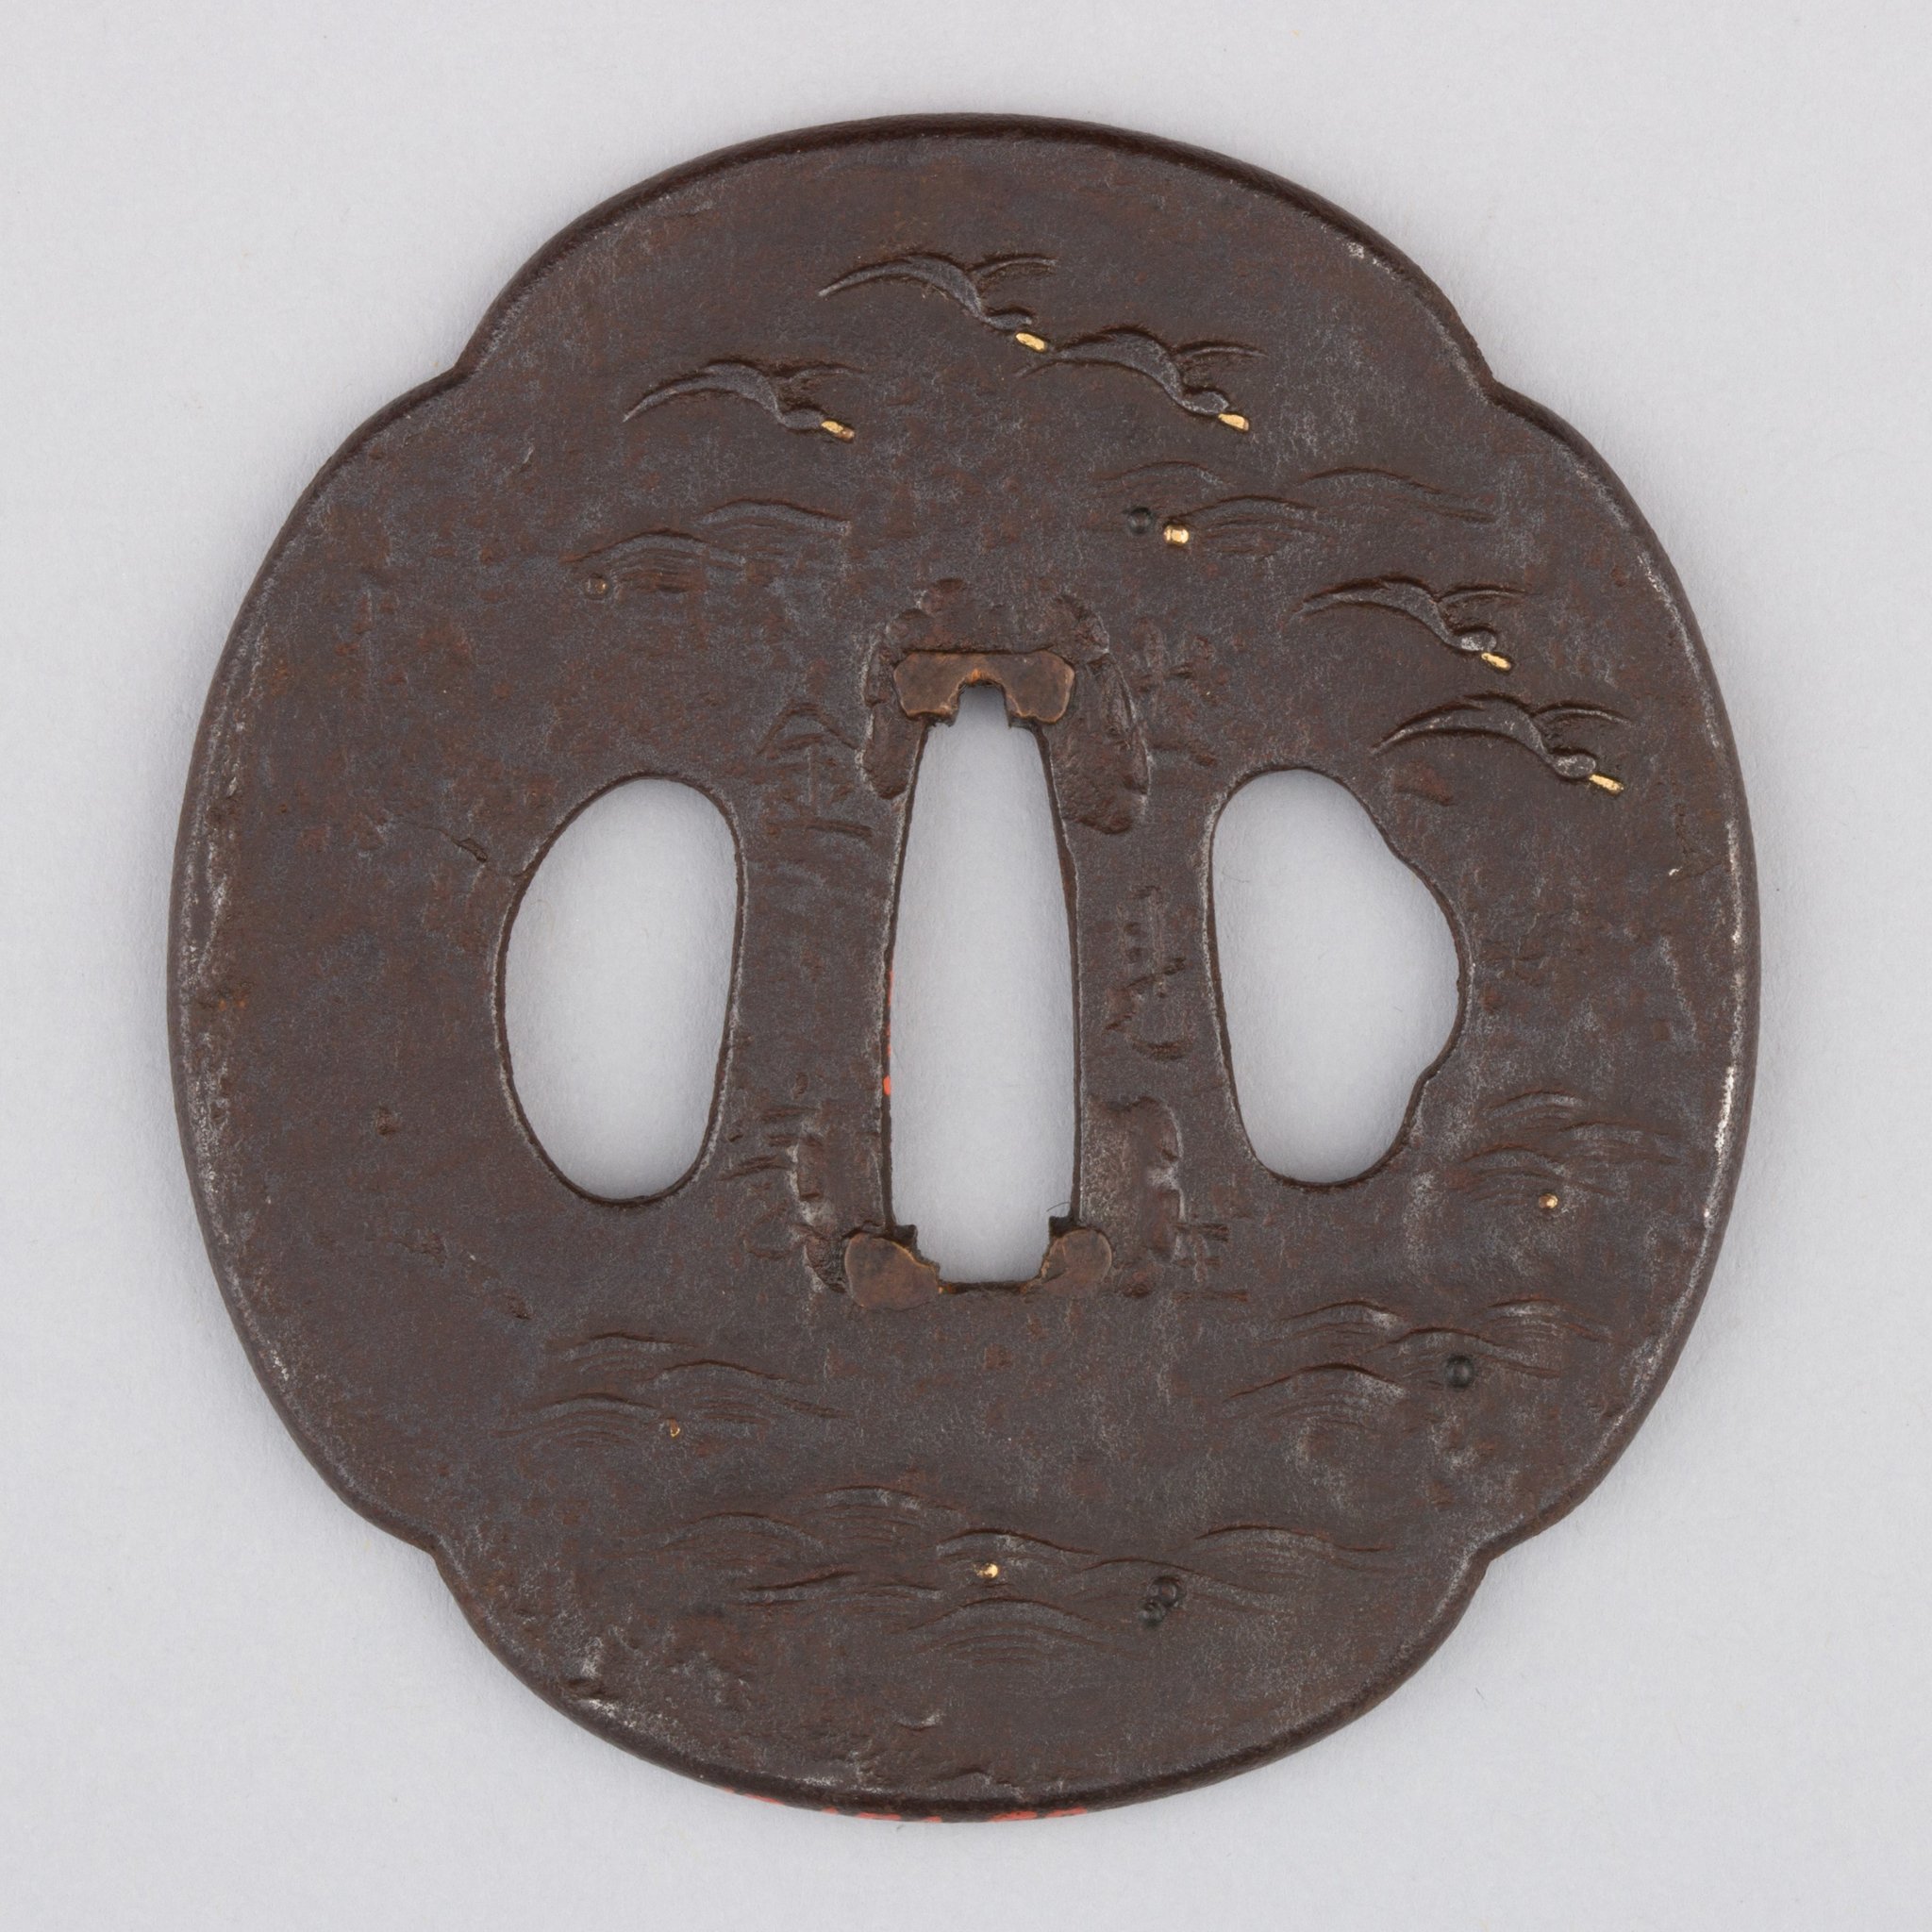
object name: sword guard tsuba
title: Sword Guard (Tsuba)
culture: japanese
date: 1667-1700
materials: copper, iron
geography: japan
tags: geese